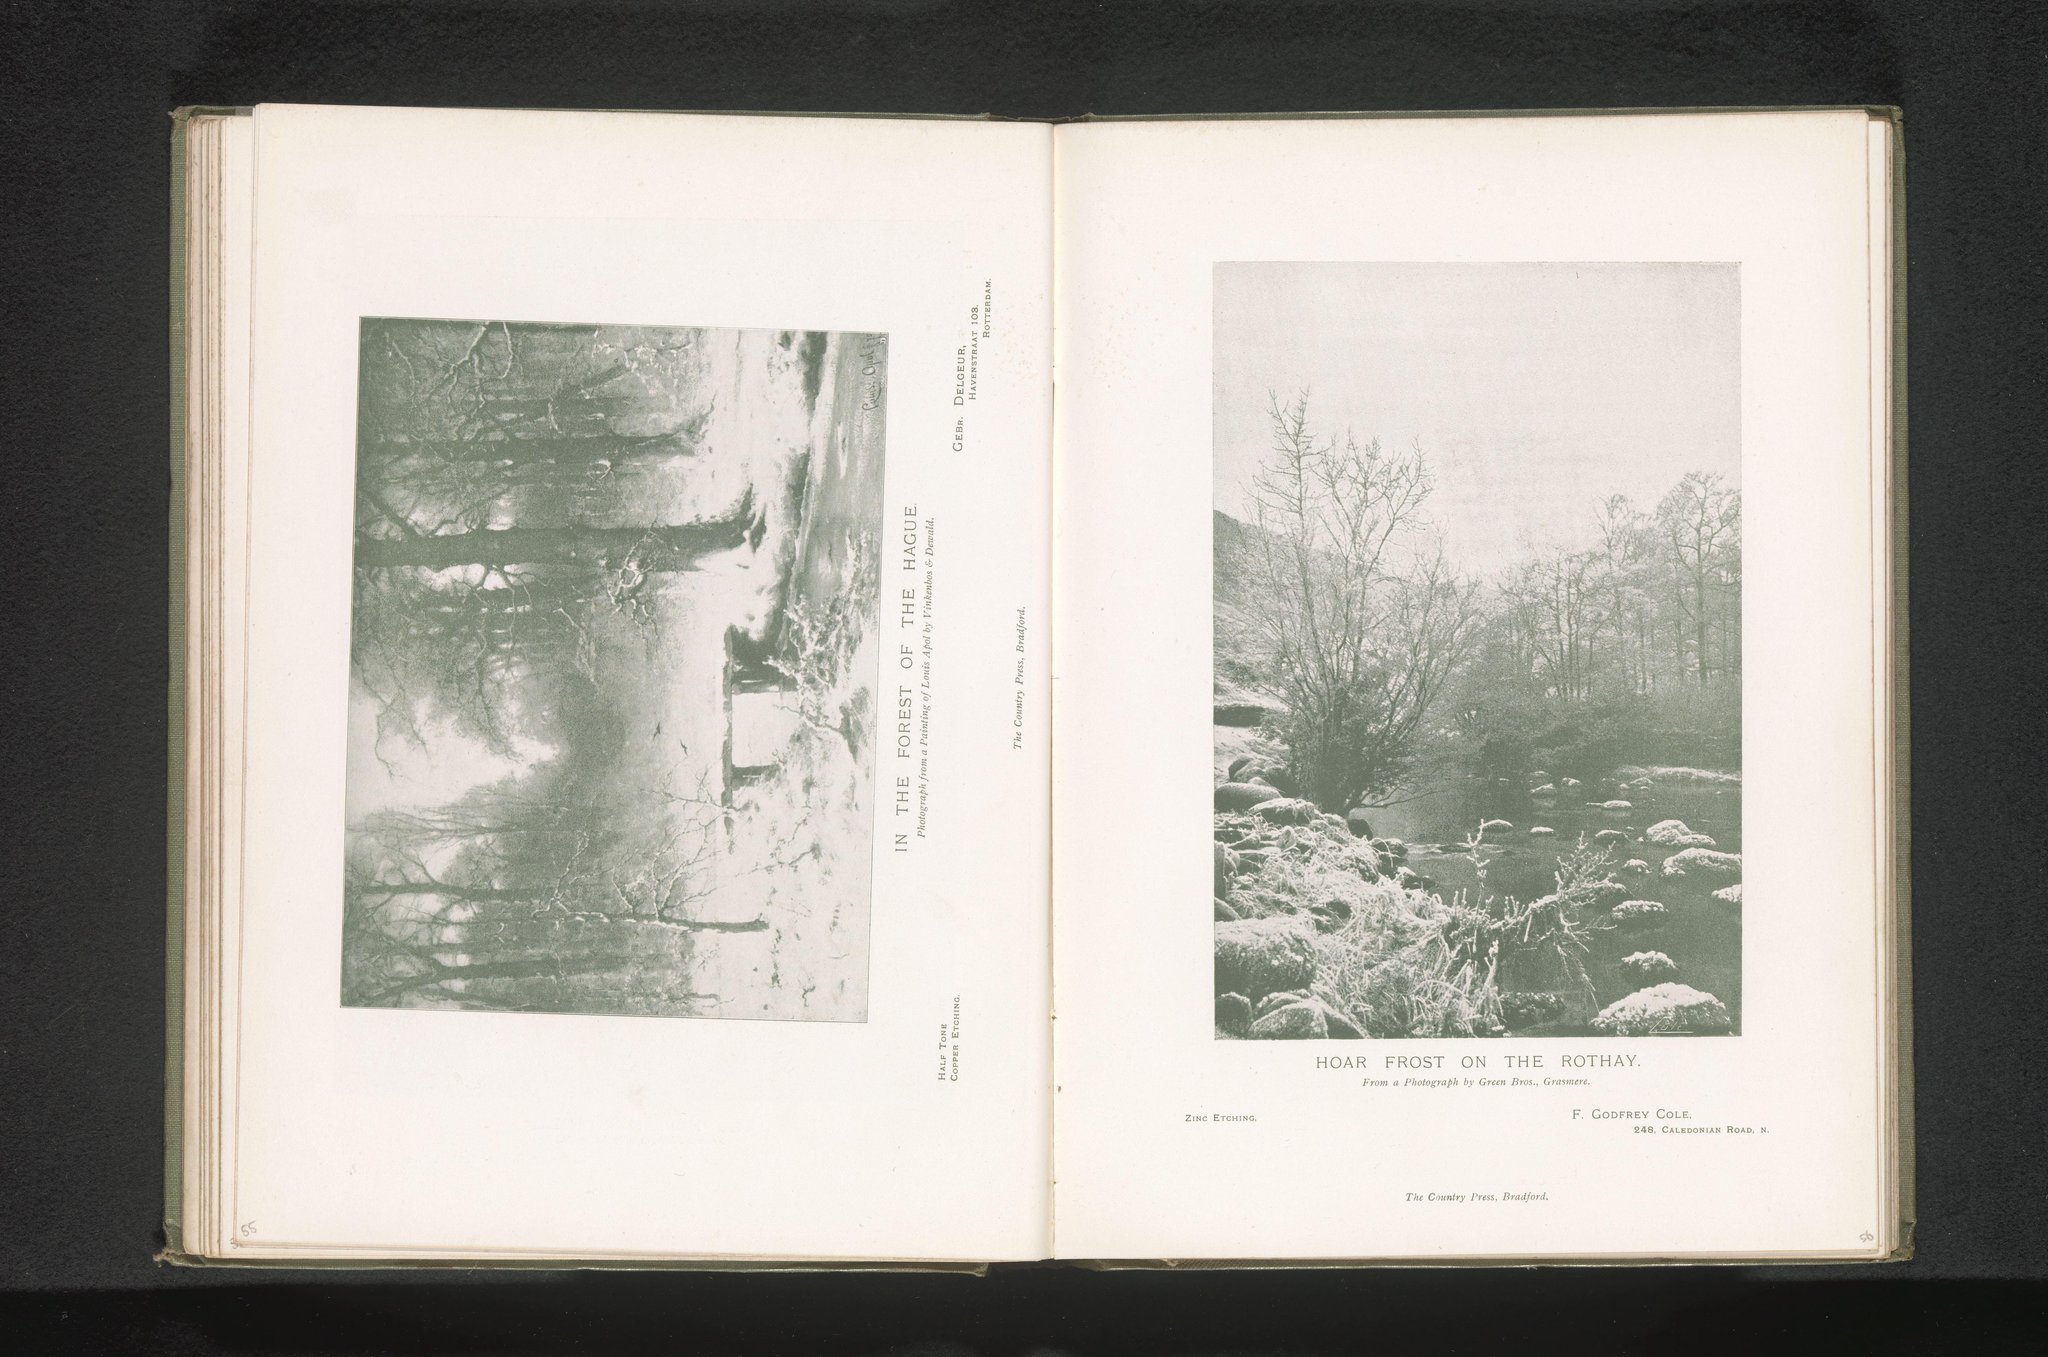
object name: page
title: In the forest of The Hague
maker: louis apol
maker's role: draughtsman, painter, print maker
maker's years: 1850-1936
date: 1893-1898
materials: paper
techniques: autotype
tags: forest, wood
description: Prent op tweede ongenummerde pagina na pagina 72.